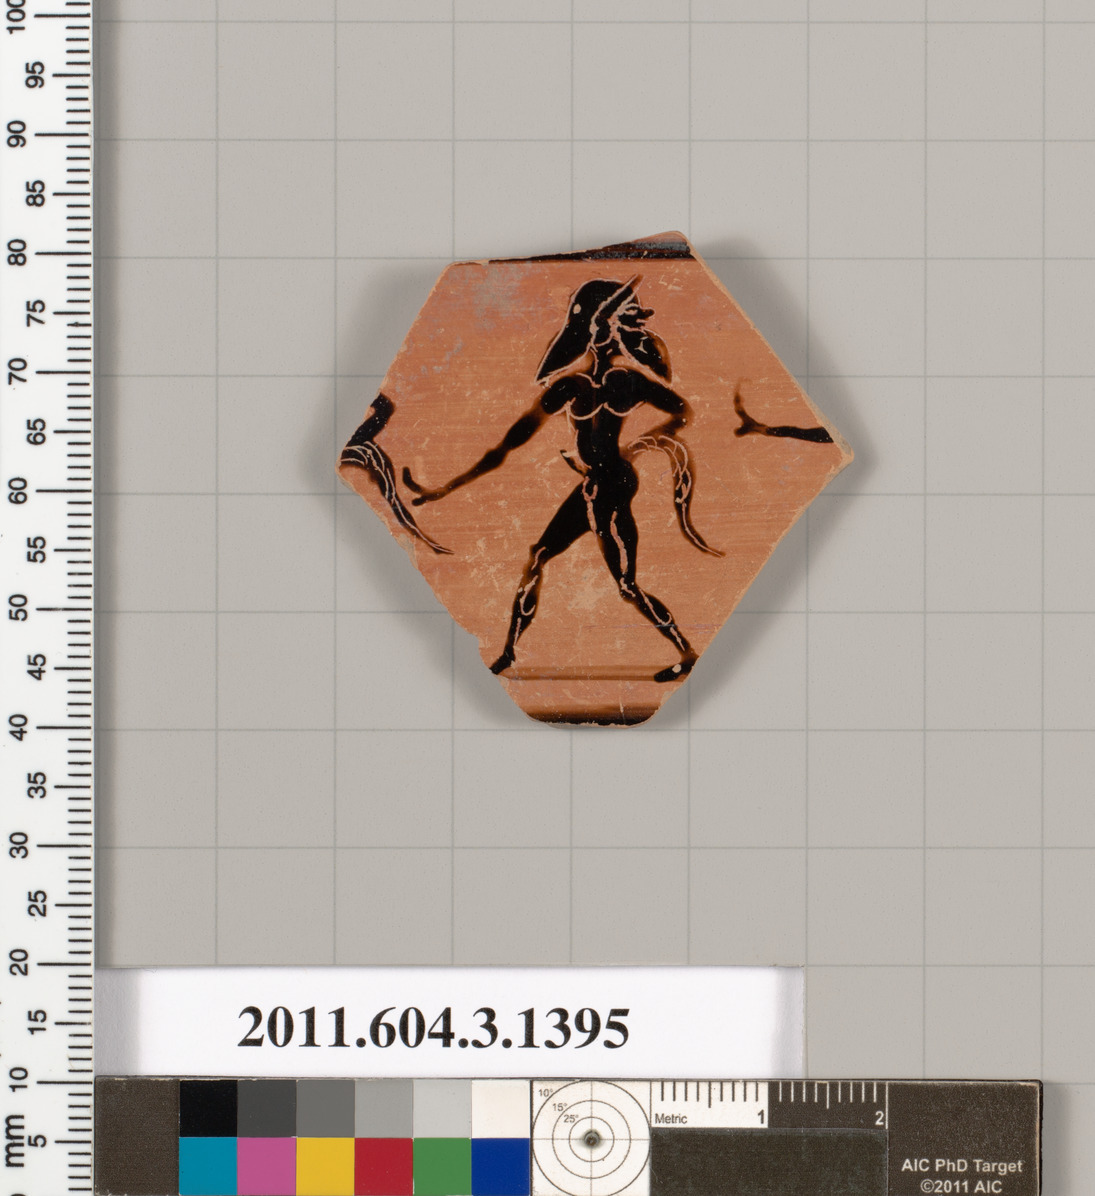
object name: skyphos fragment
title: Terracotta fragment of a skyphos (deep drinking cup)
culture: greek, attic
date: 534-468 BCE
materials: terracotta